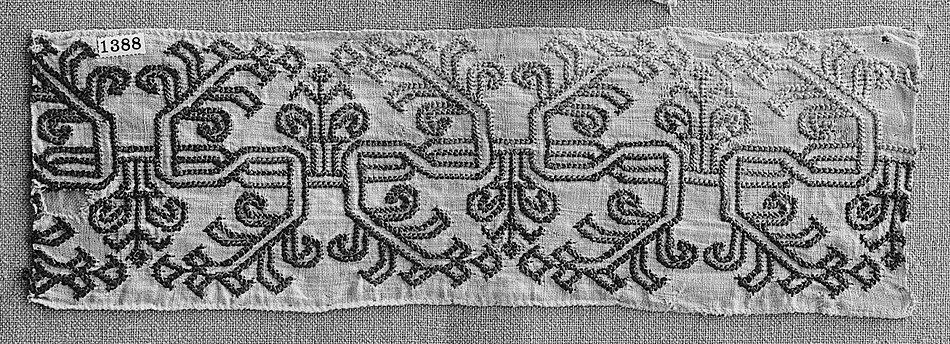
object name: band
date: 1501-1700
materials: linen, silk